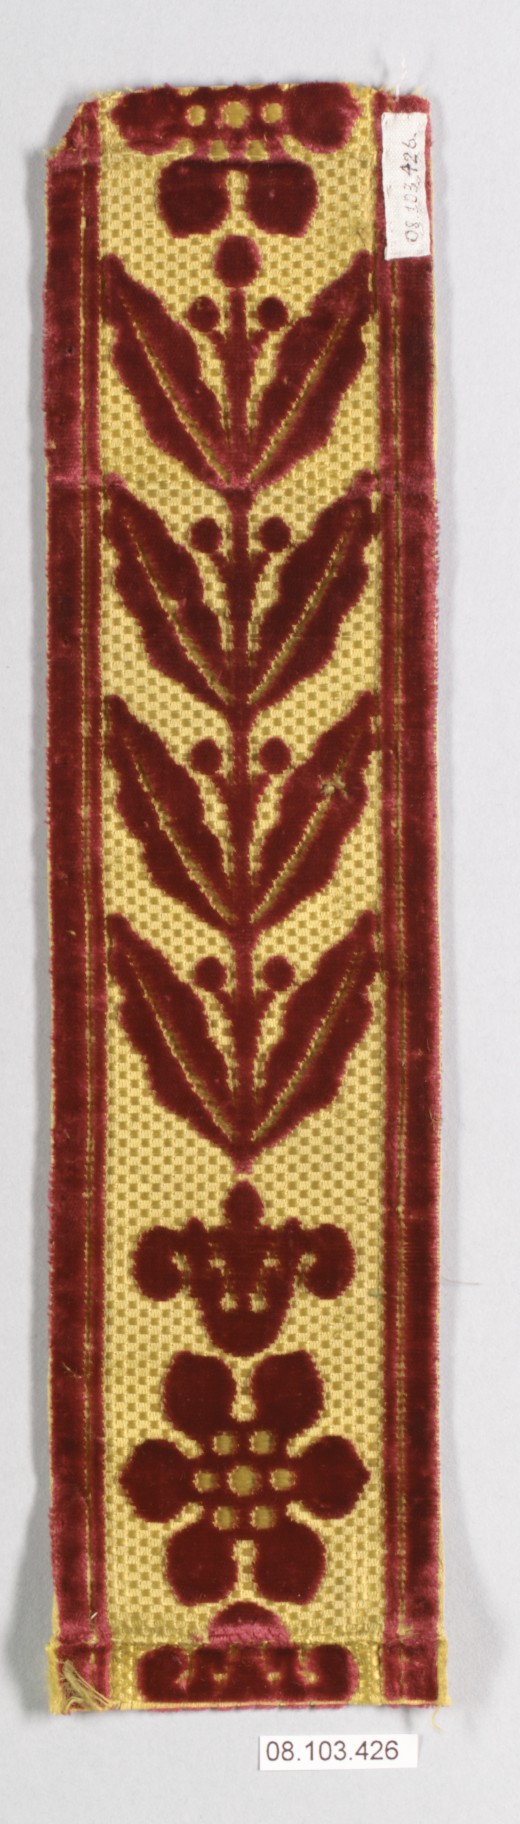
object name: galloon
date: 1801-1900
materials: silk